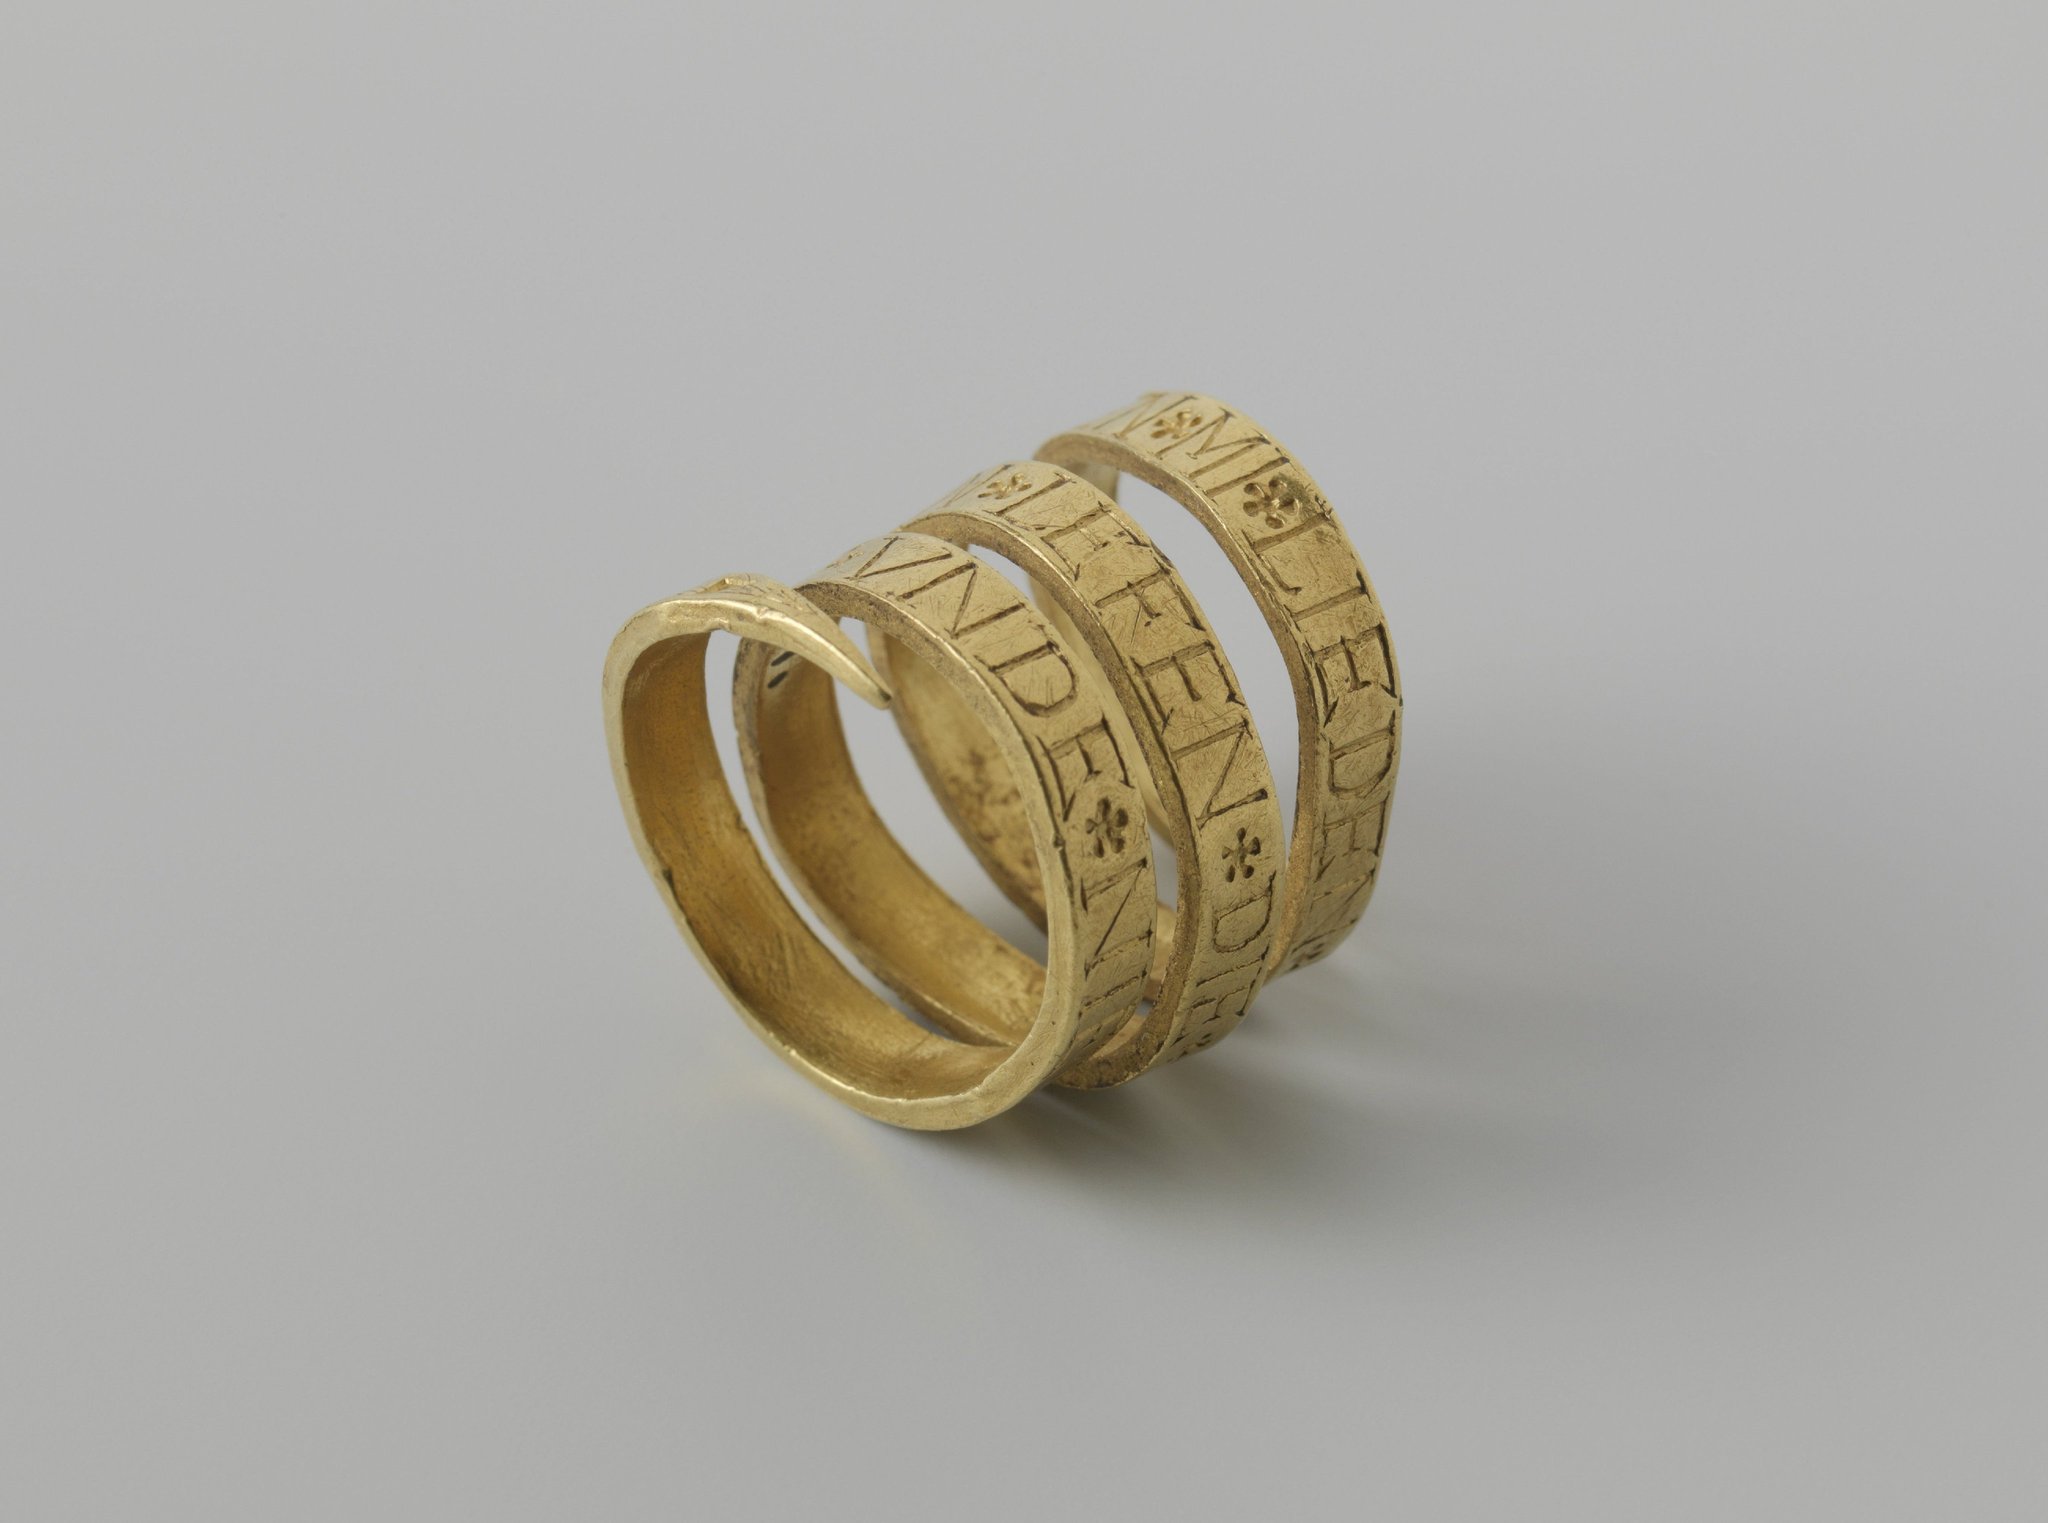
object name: ring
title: Ring met inscriptie: SIE MOETEN MI LIEDEN UNDE LAETEN LEFEN, DIE MI BENIEDET UNDE NIET ON GEFEN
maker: Anonymous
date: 1540-1560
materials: gold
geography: northern netherlands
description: Ring van goud. In de vorm van een platte spiraal. Hierop in romeinse letters de inscriptie 'Sie moeten mi lieden unde laeten lefen die mi beniedet unde niet on gefen (laat hen, die mij benijden, mij dulden en laten leven, als ze me (maar) niets afnemen).